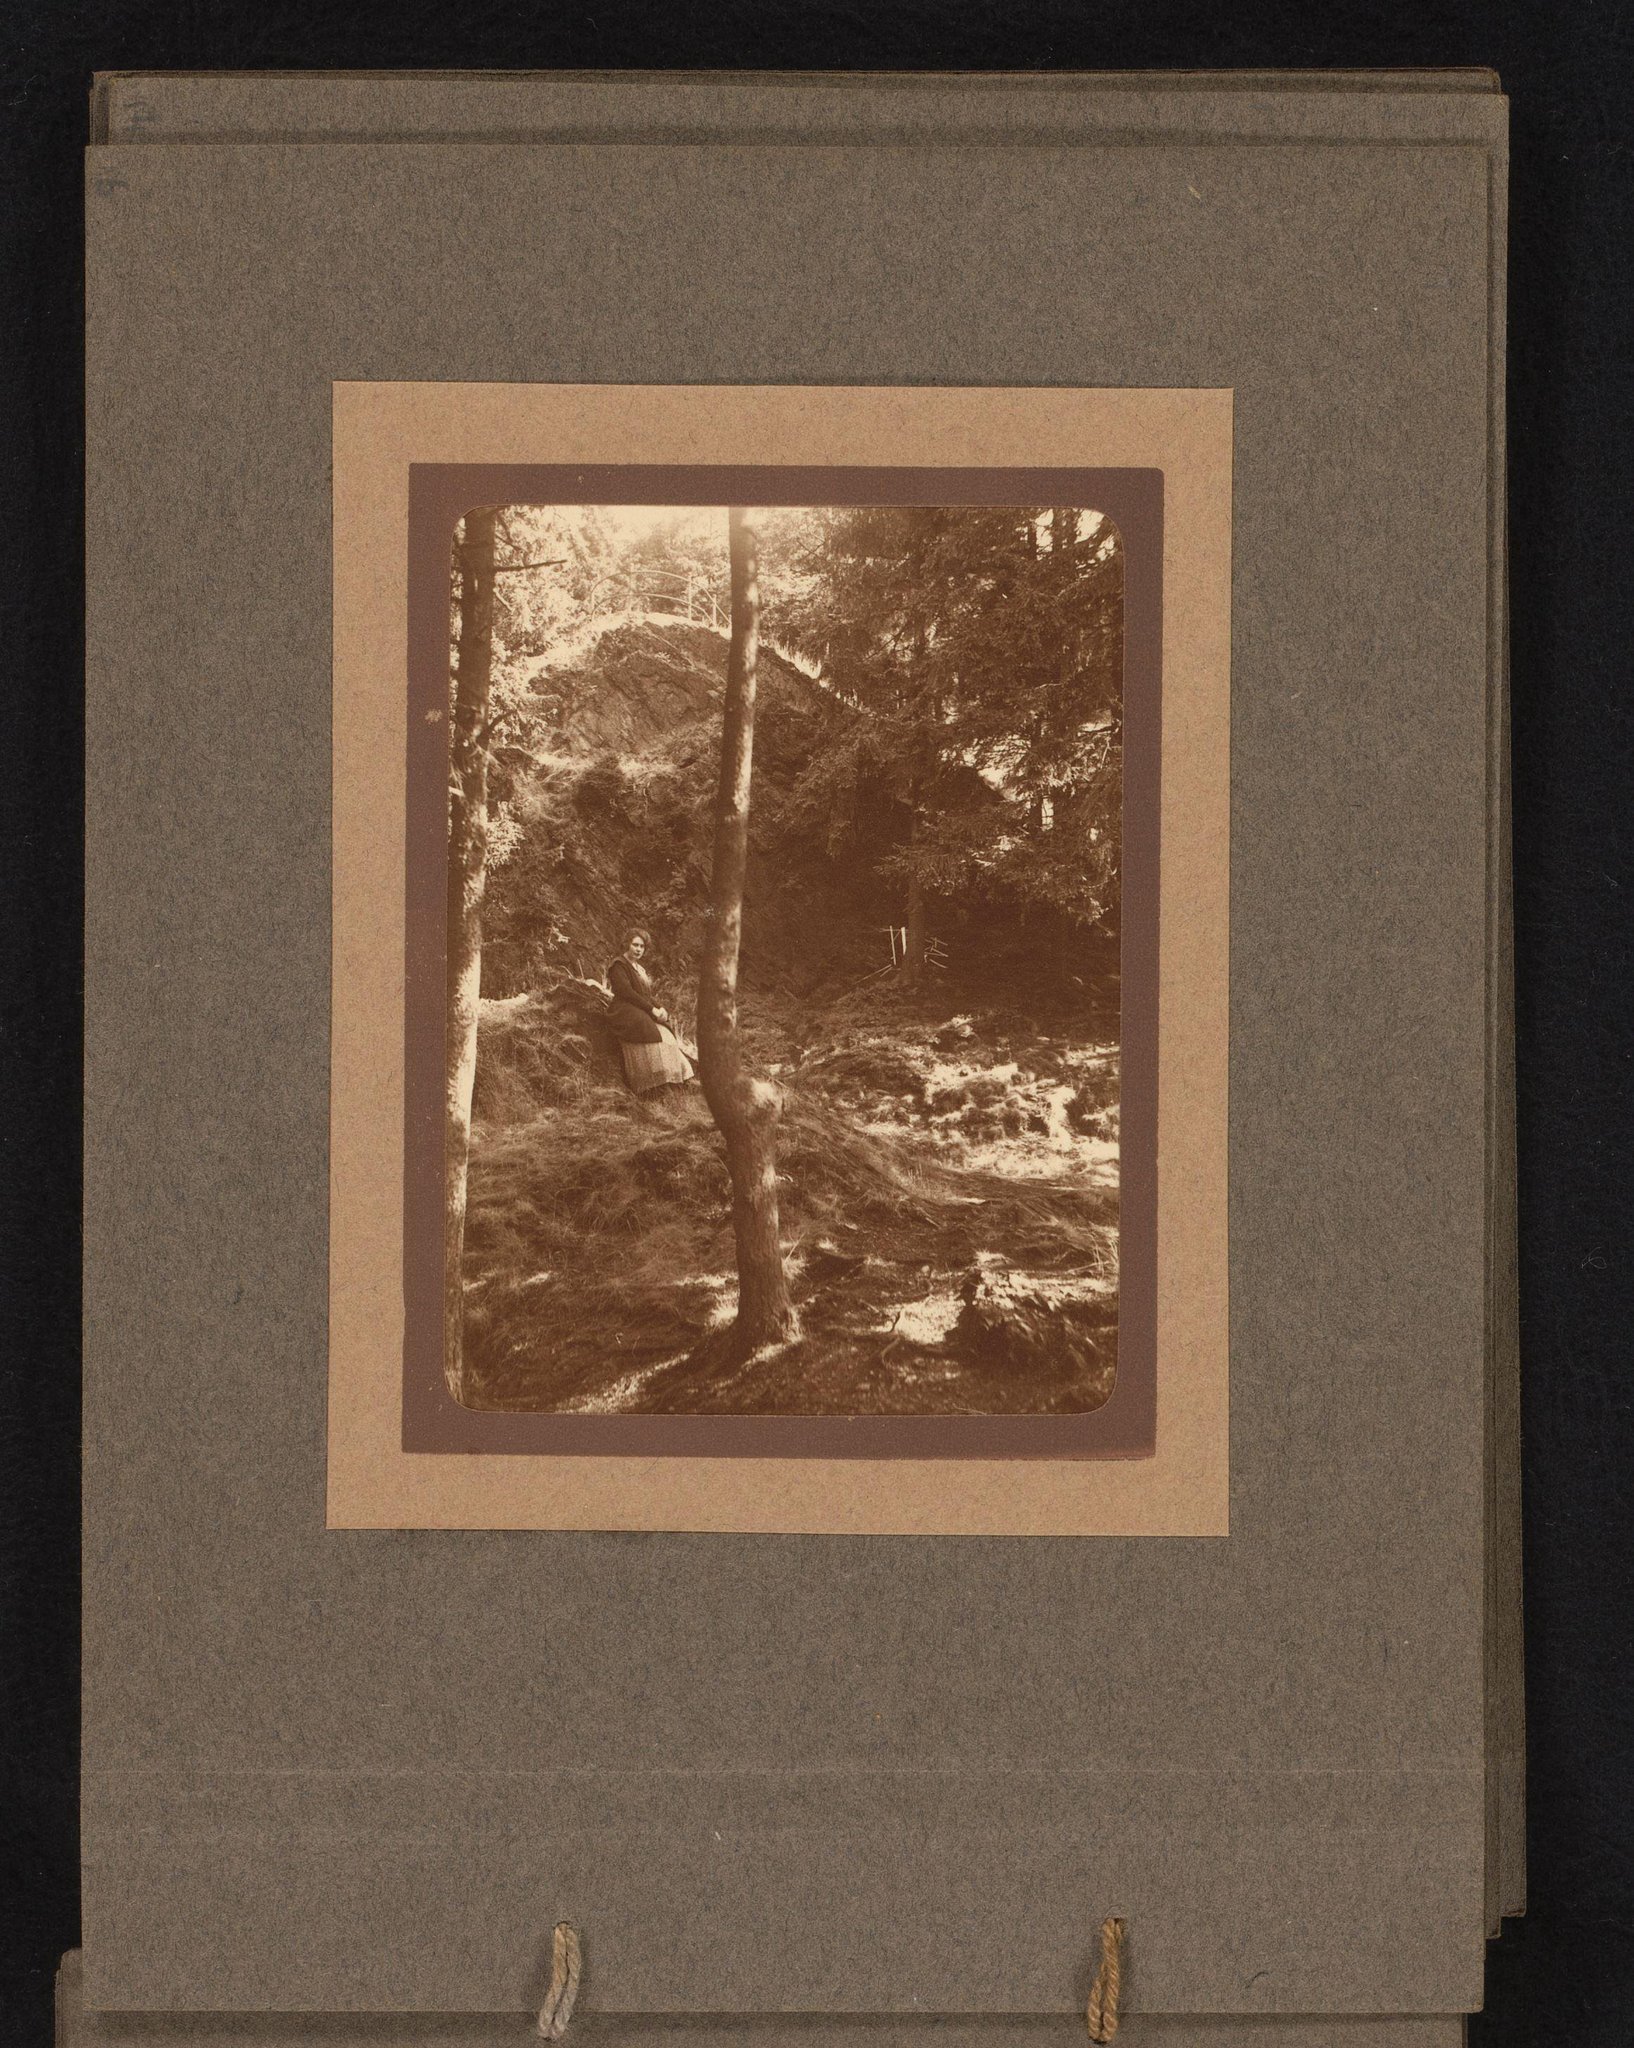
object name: photograph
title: Vrouw in een bos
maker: Anonymous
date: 1880-1930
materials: cardboard, photographic support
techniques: collodion silver print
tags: trees, adult woman, forest, wood